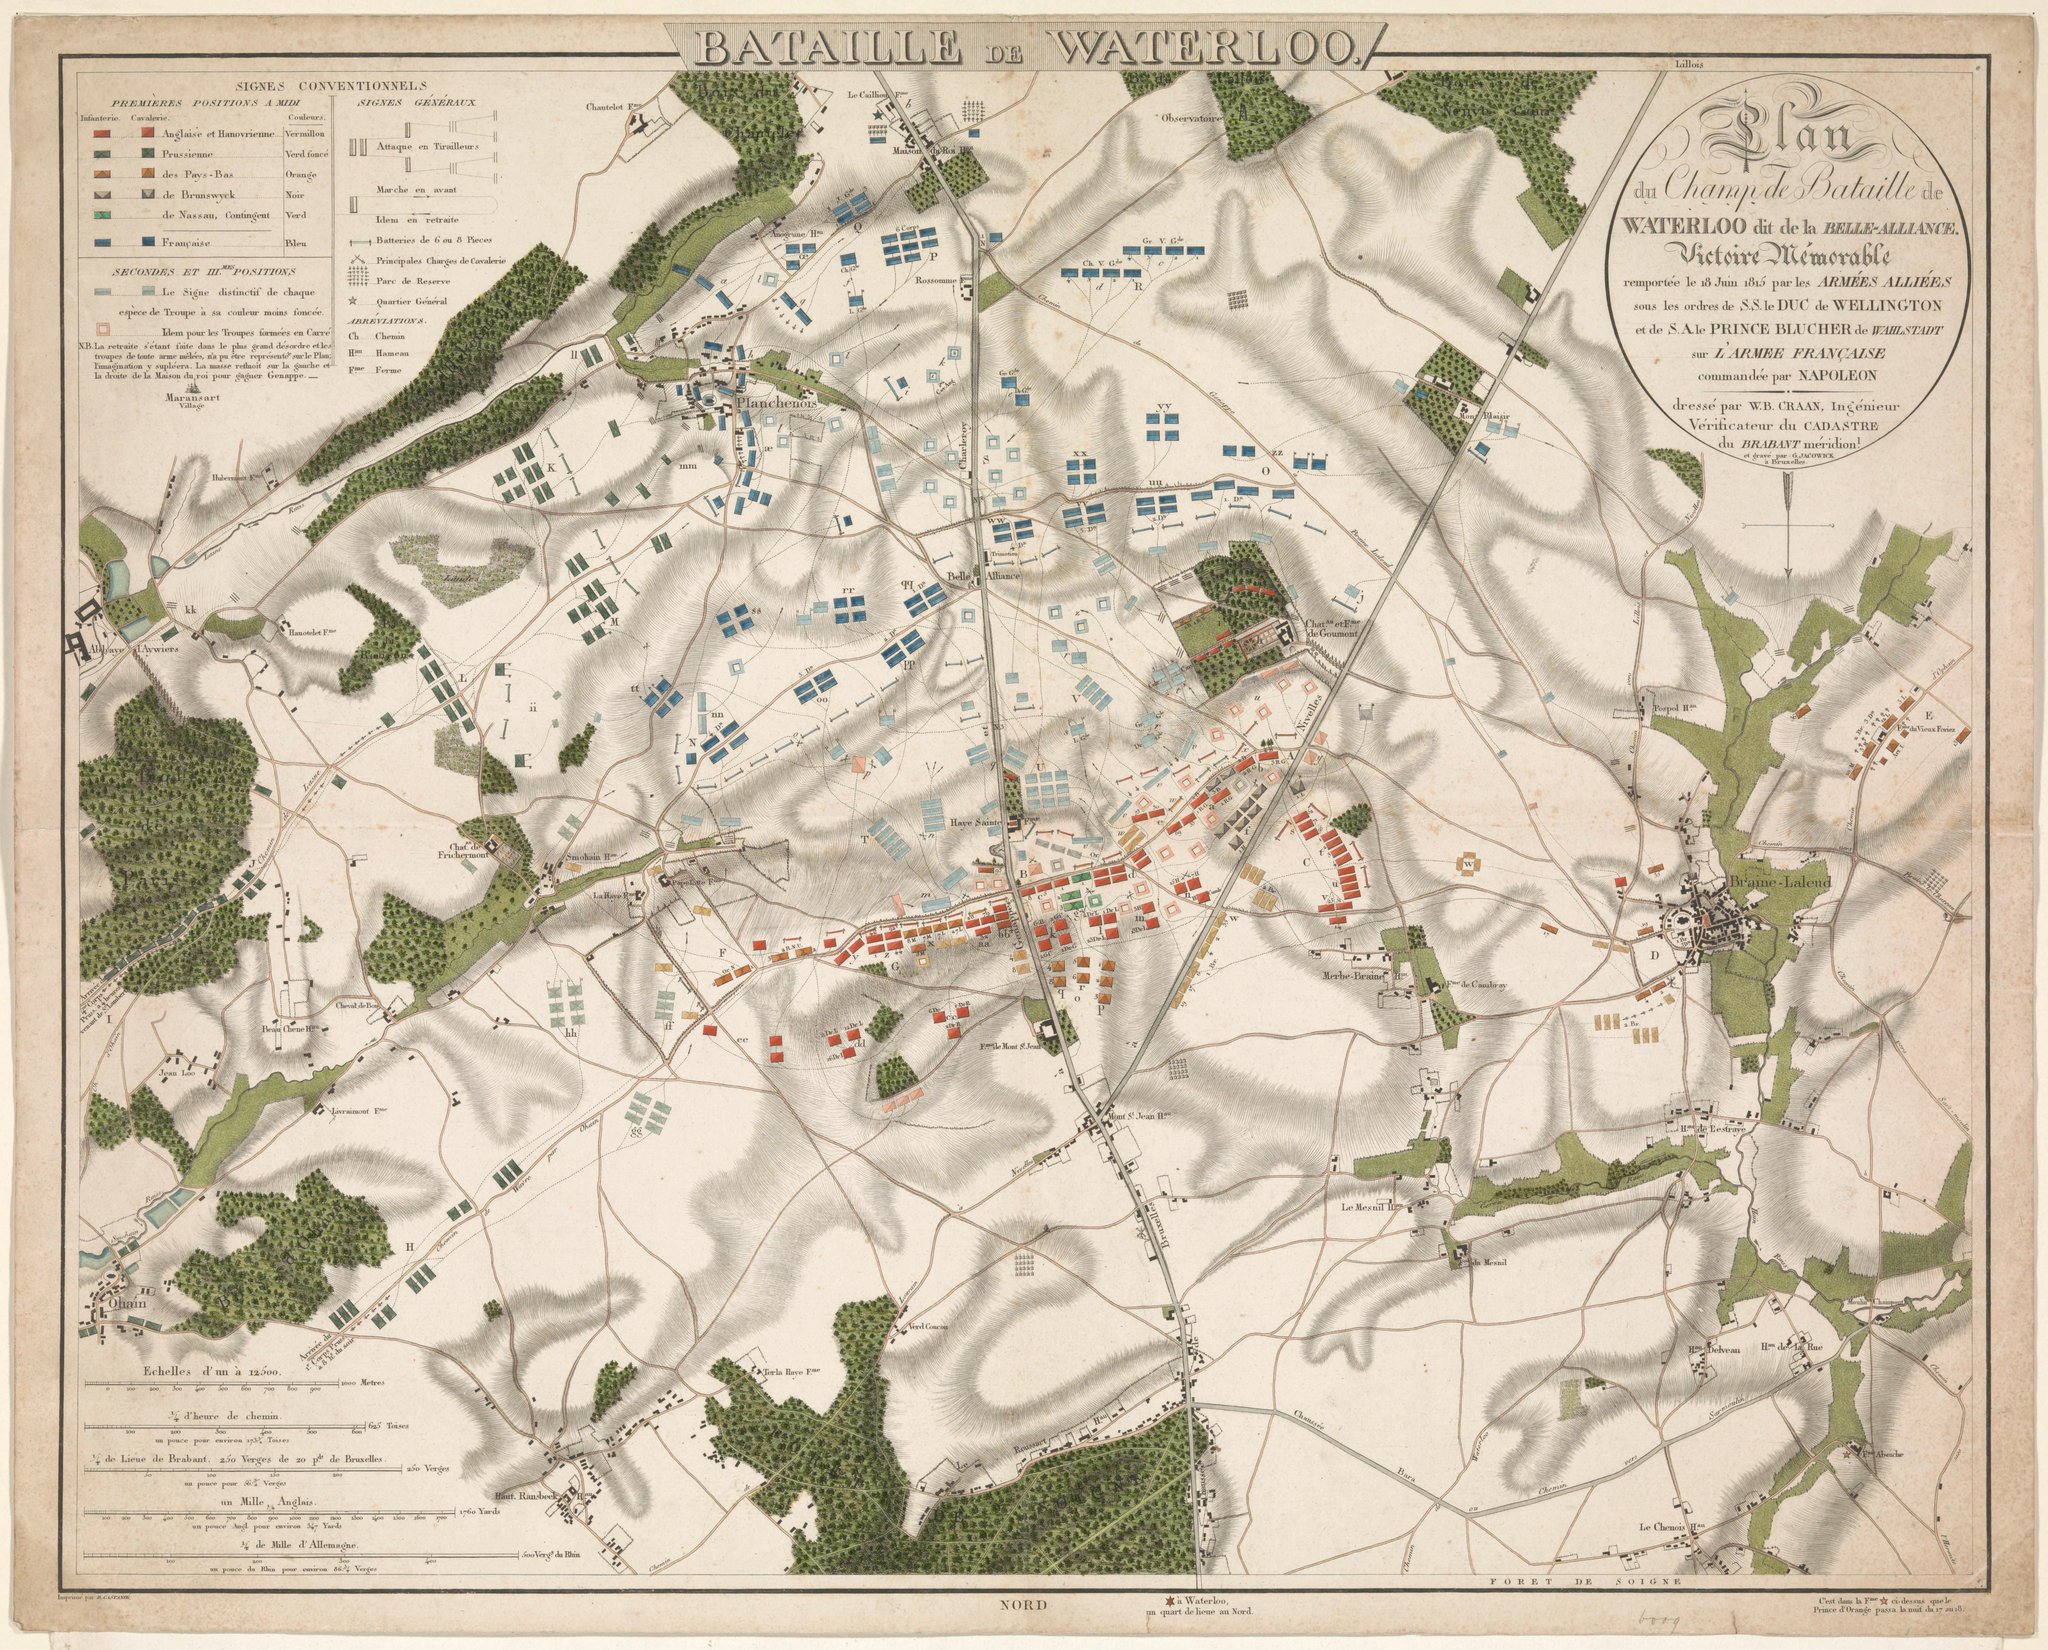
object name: print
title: Kaart van de Slag bij Waterloo, 1815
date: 1809-1816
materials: paper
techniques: engraving, etching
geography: brussels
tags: battle (+ land forces), waterloo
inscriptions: collector's mark: Lugt 2228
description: Kaart van het terrein waar de Slag bij Waterloo plaatsvond op 18 juni 1815. Op kaart staan de posities van de verschillende legers aangegeven. Linksboven de legenda. Bij de prent behoort een afzonderlijke verklaring.